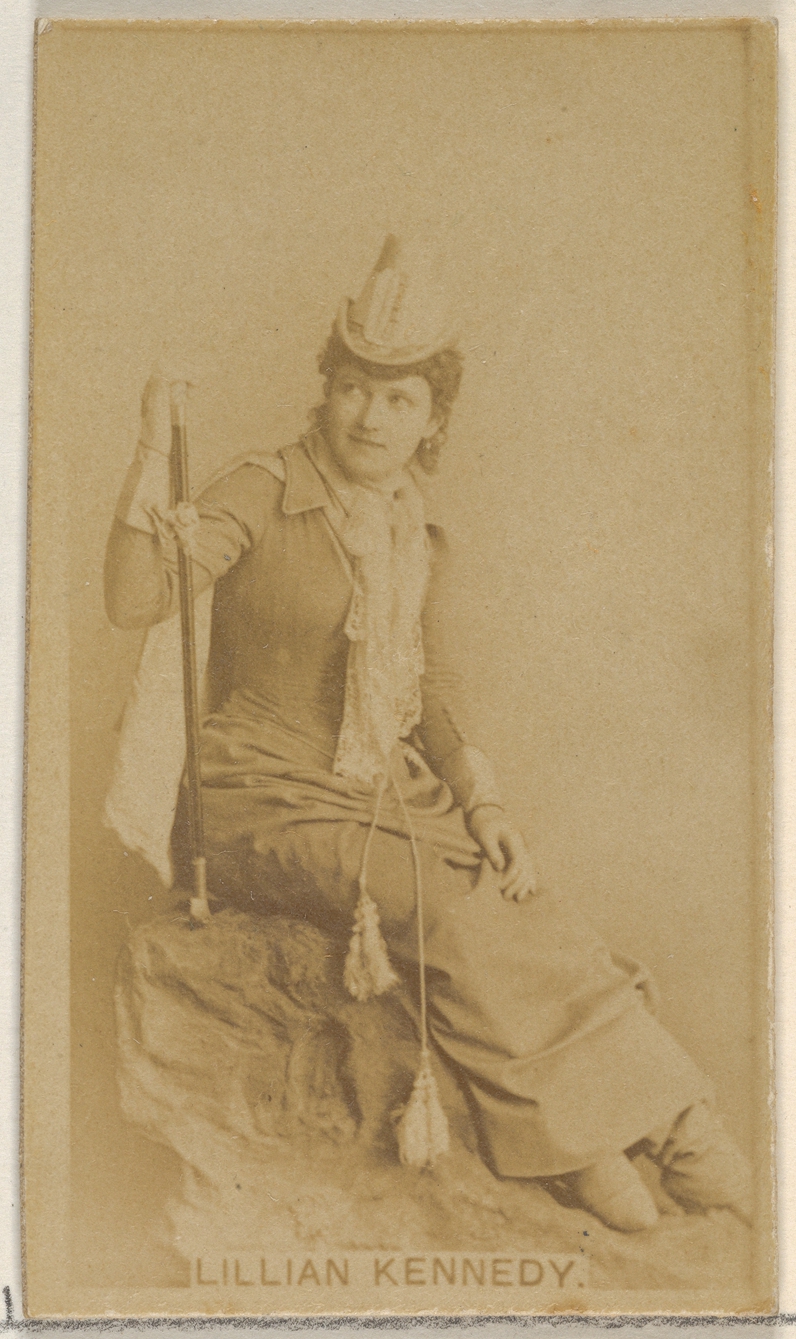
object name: photograph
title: Lillian Kennedy, from the Actors and Actresses series (N45, Type 8) for Virginia Brights Cigarettes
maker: allen & ginter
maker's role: publisher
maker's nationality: american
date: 1888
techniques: albumen silver print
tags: portraits,women,actresses